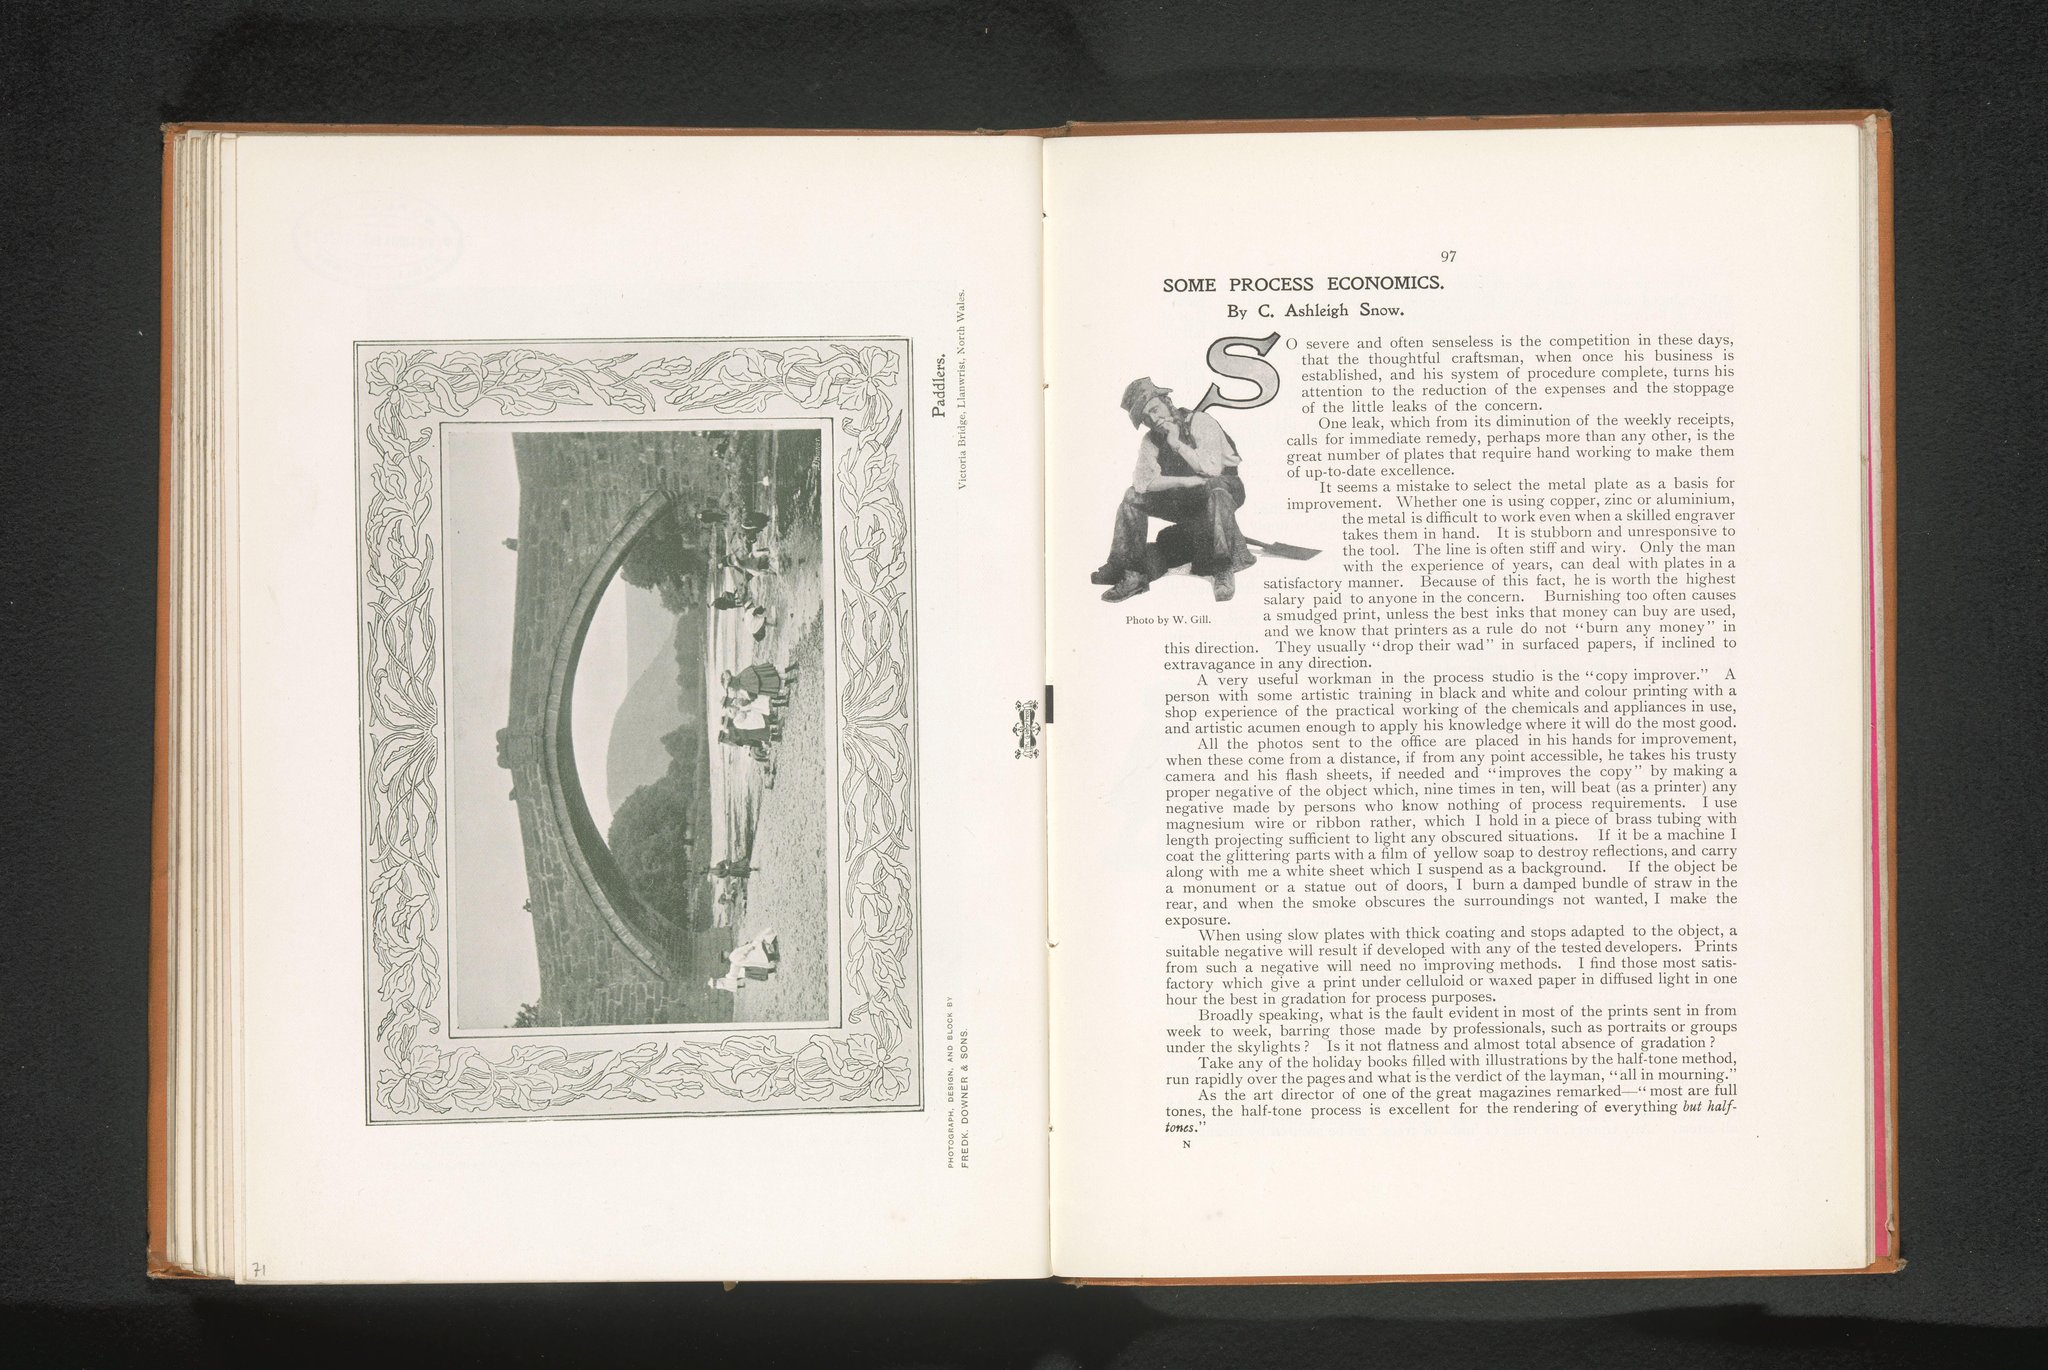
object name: photomechanical print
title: Evening on the Common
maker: Anonymous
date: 1894-1899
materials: paper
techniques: autotype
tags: landscape with bridge, viaduct or aqueduct (+ city(-scape) with figures, staffage)